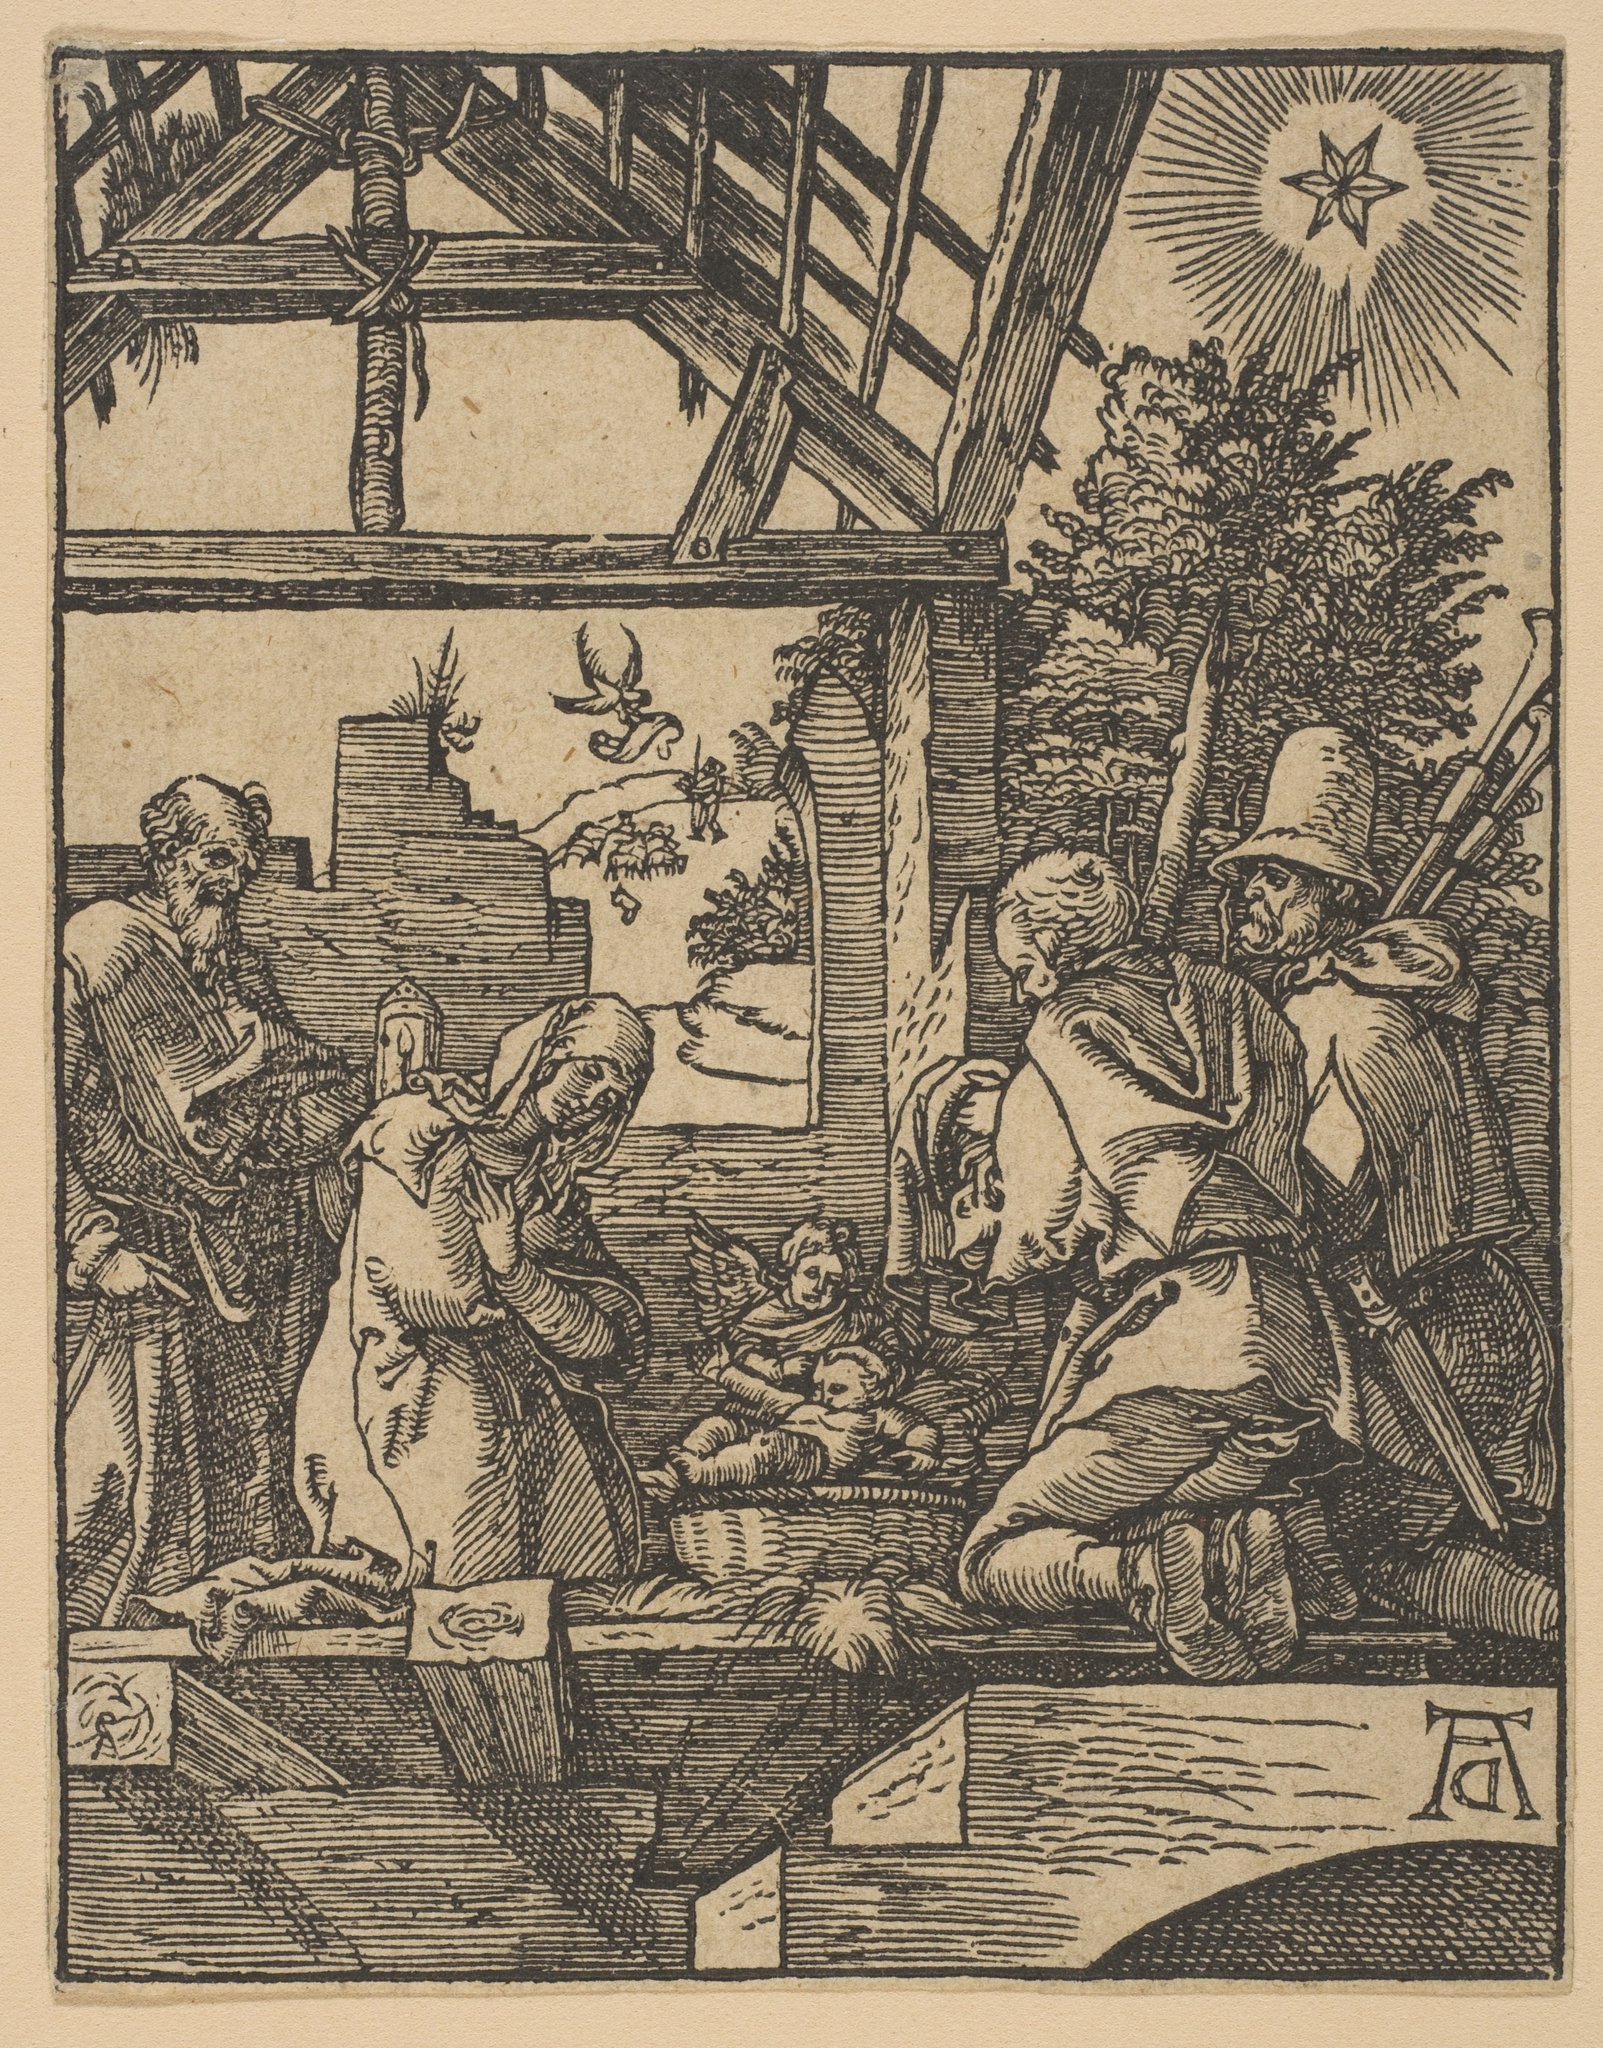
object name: print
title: The Nativity (copy)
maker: albrecht dürer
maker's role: artist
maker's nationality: german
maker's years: 1471-1528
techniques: woodcut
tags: nativity